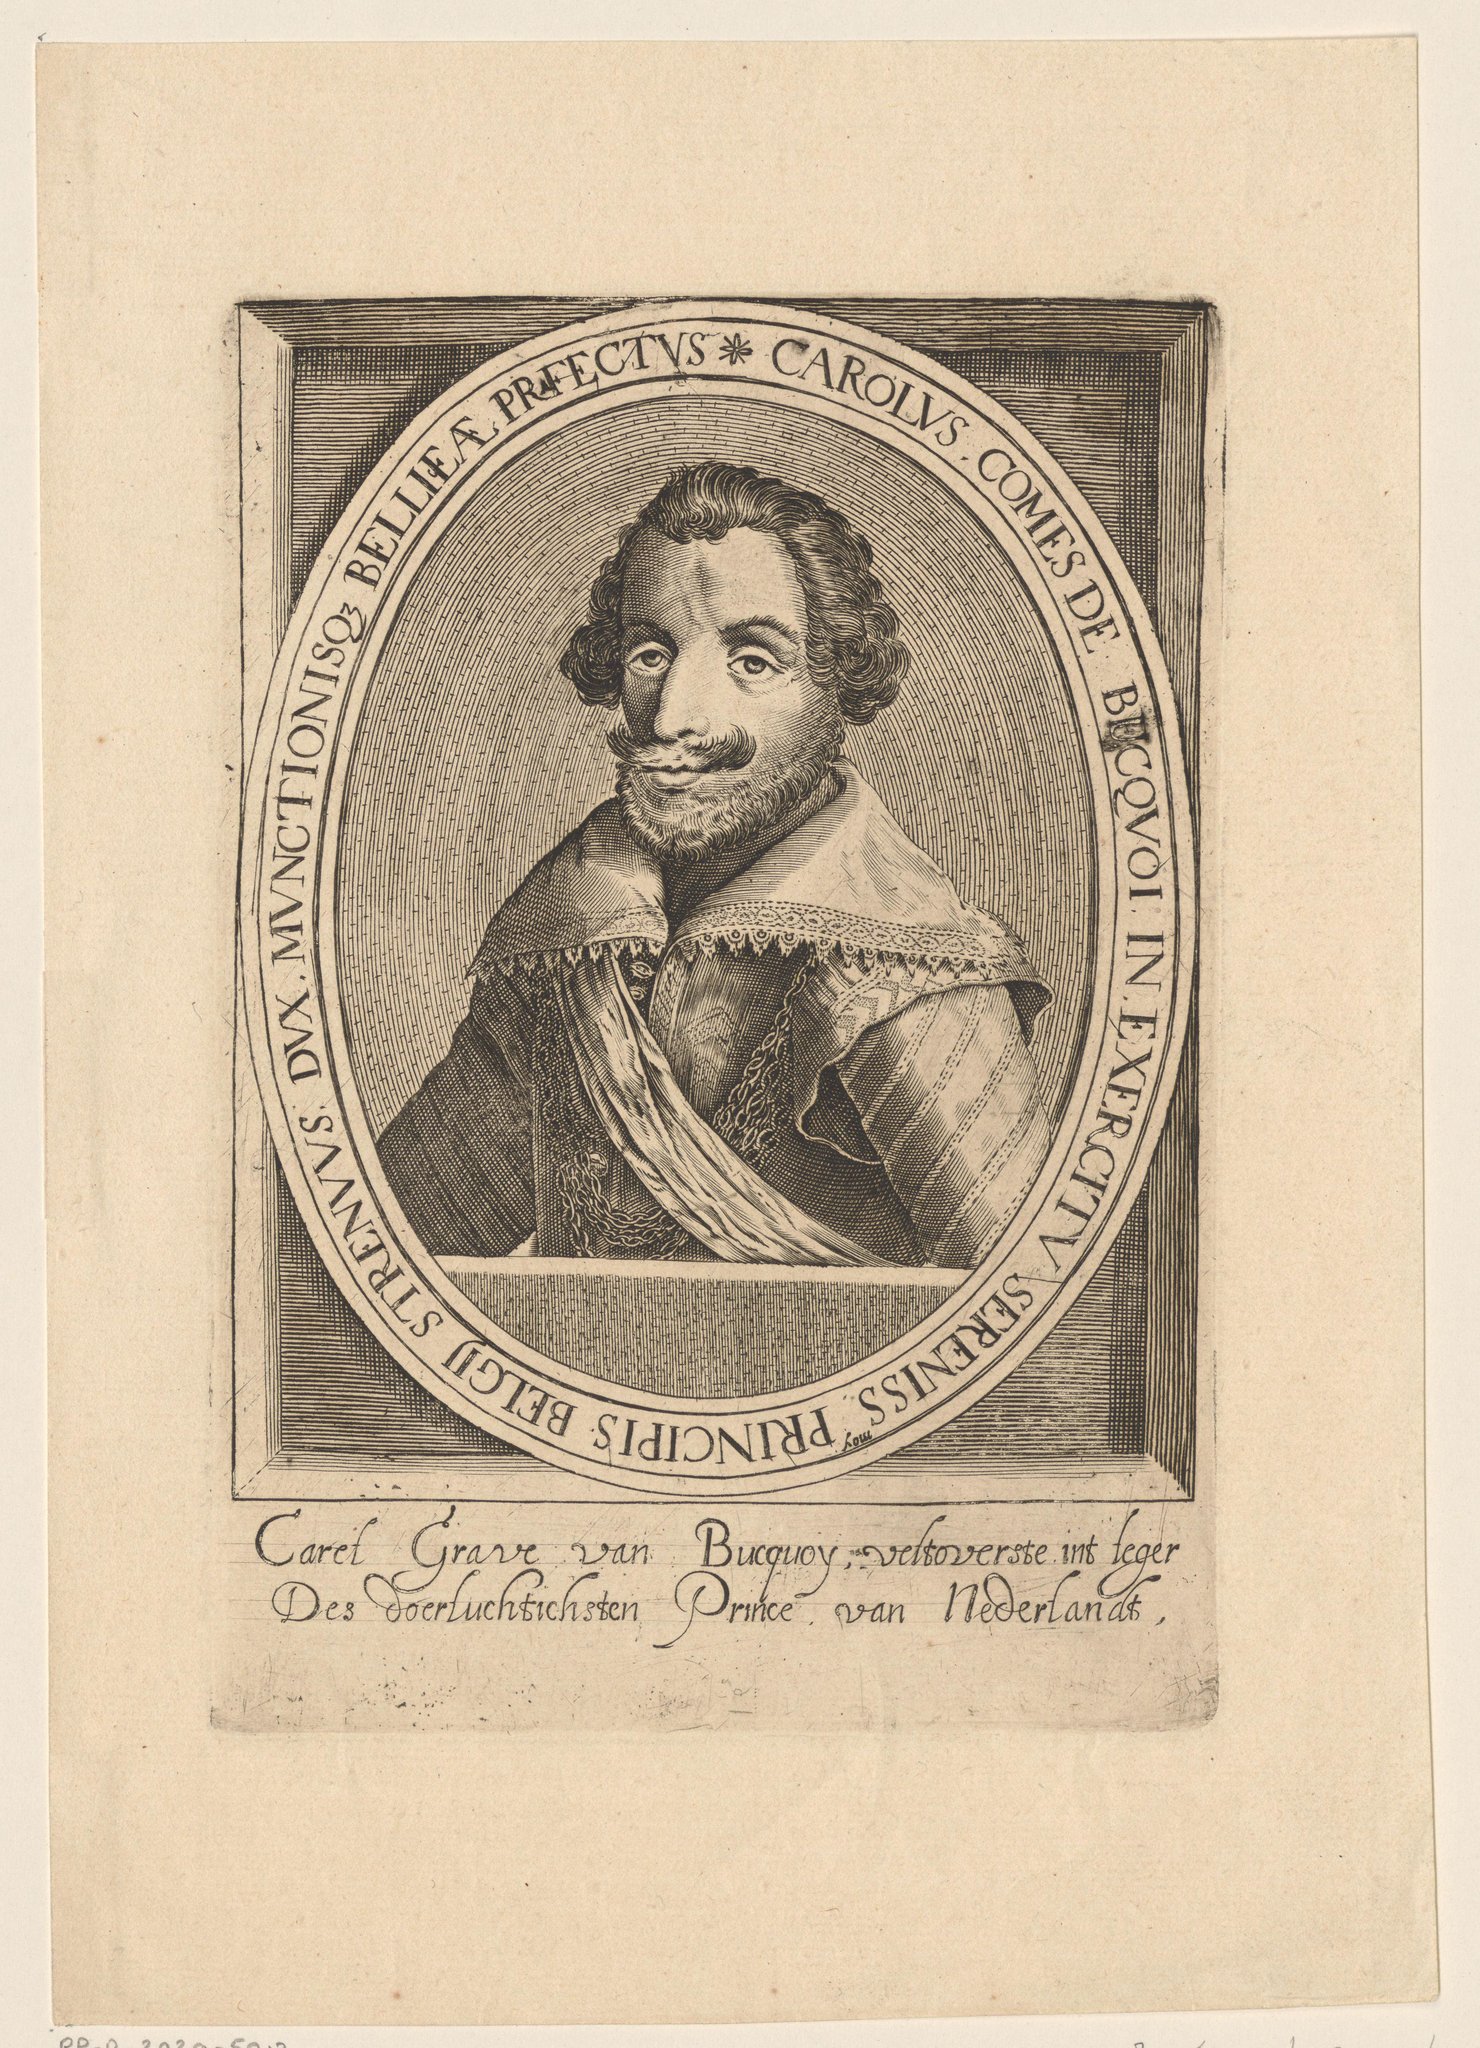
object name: print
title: Portret van Karel Bonaventura van Longueval, graaf van Bucquoy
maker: Anonymous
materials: paper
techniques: engraving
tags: historical persons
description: Prent waarschijnlijk uit: Baudartius, Willem. Memoryen ofte cort verhael der gedenck-weerdichste so kercklicke als werltlicke gheschiedenissen (...). Zutphen: Andries Jansz., 1625, dl. 2.